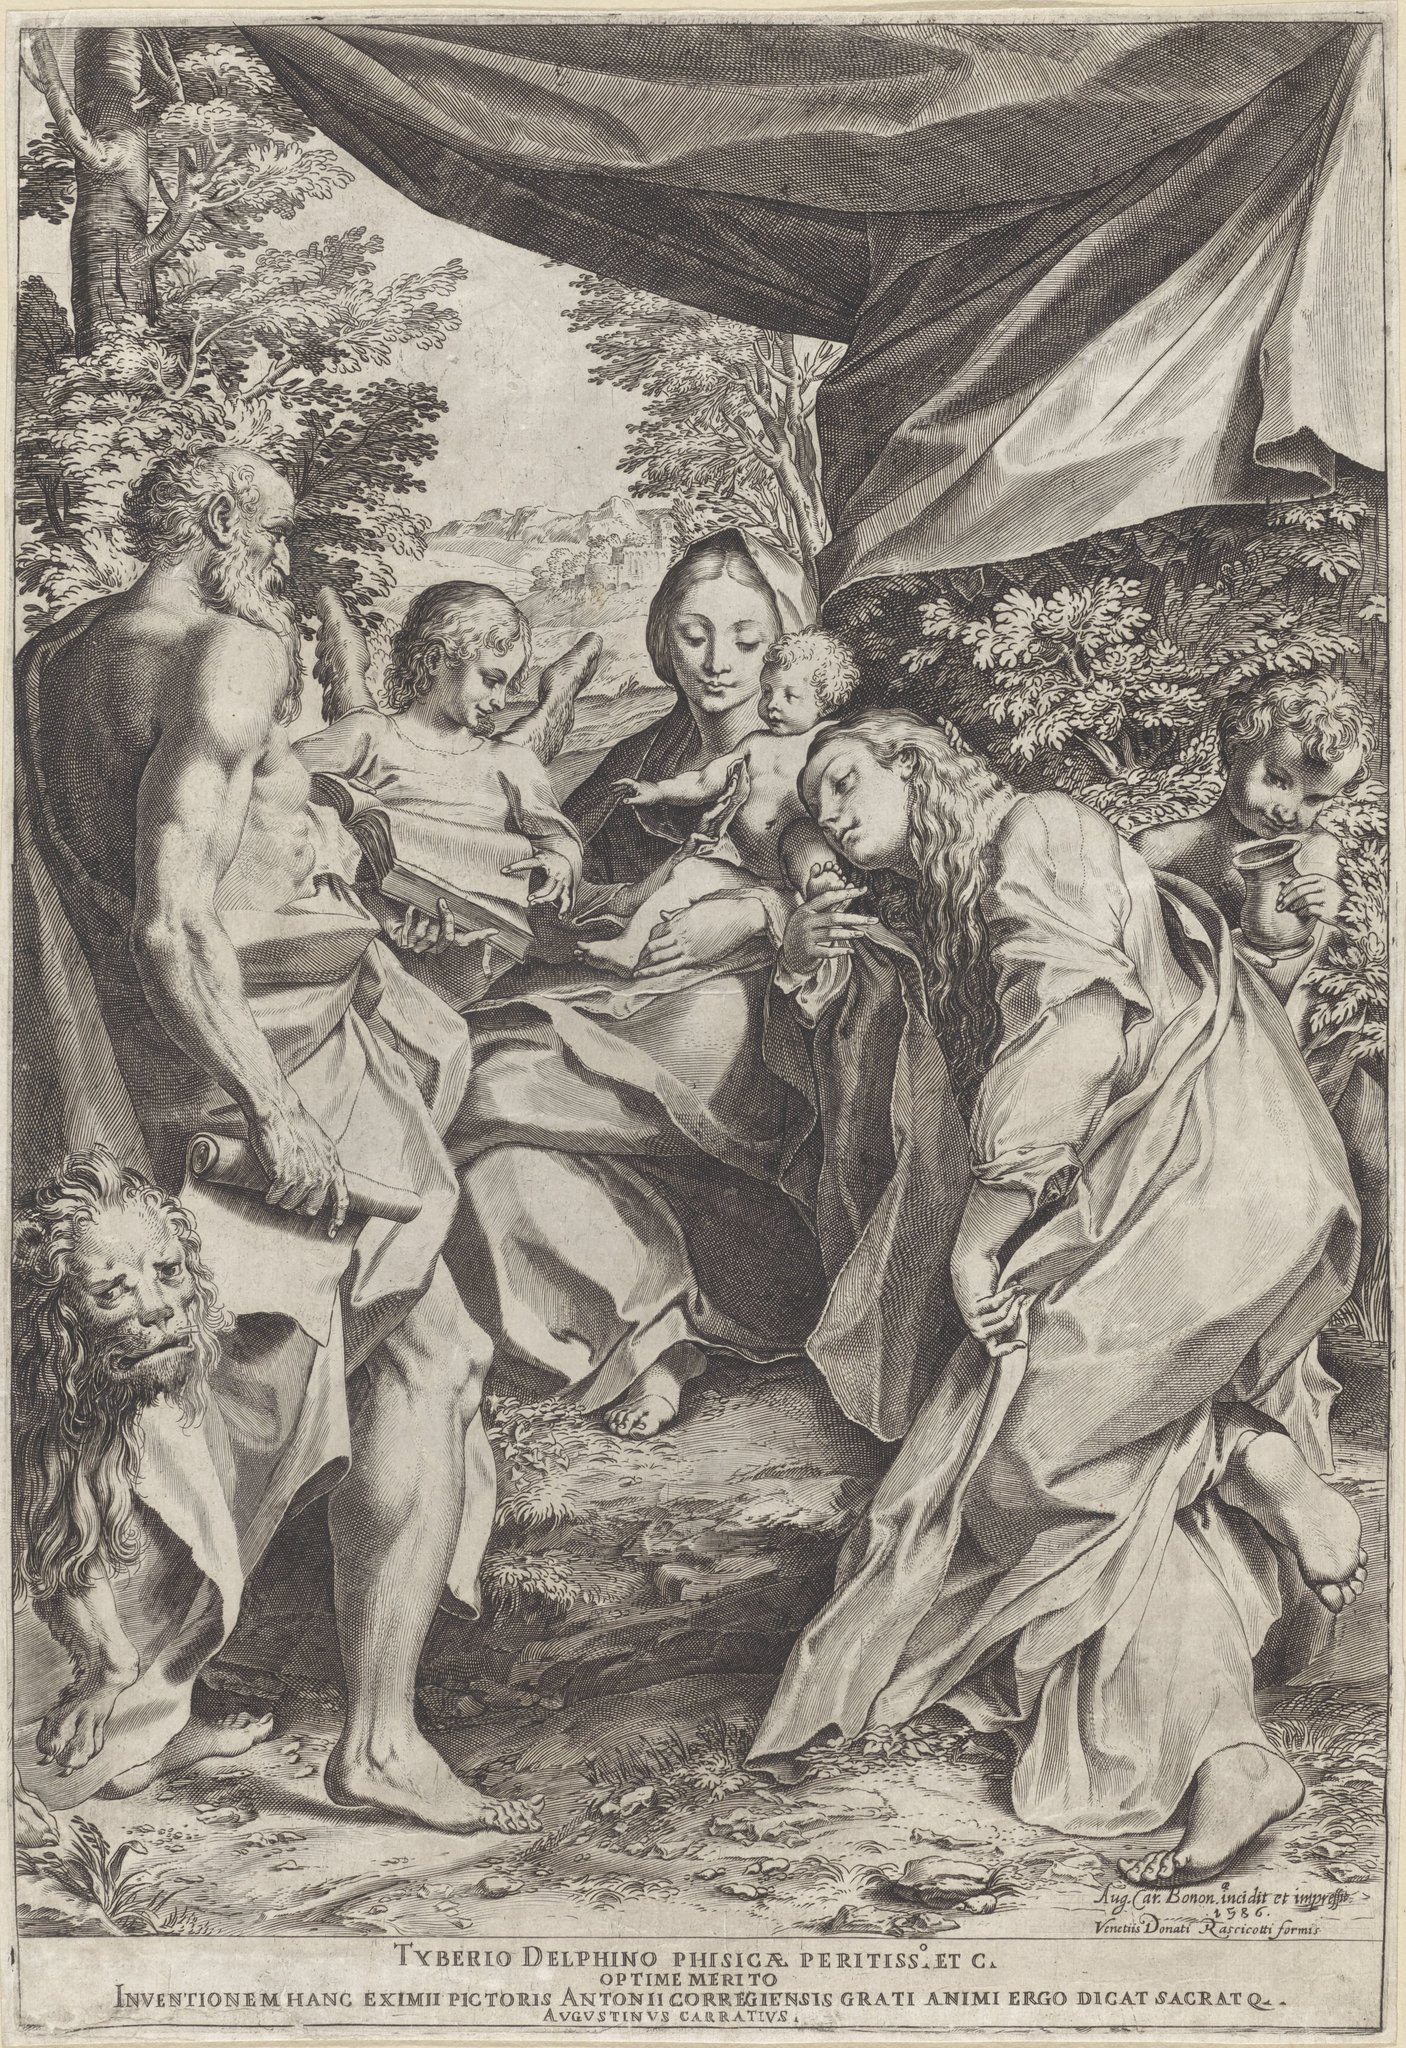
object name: print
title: Maria met Kind en de heilige Hieronymus en Maria Magdalena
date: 1586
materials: paper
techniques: engraving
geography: italy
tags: madonna accompanied by saint(s), the monk and hermit jerome (hieronymus); possible attributes: book, cardinal's hat, crucifix, hour-glass, lion, skull, stone, the penitent harlot mary magdalene; possible attributes: book (or scroll), crown, crown of thorns, crucifix, jar of ointment, mirror, musical instrument, palm-branch, rosary, scourge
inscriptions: collector's mark: Lugt 240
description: Het Christuskind zit bij Maria op schoot. Een engel toont hem een boek. Op de voorgrond links staat de heilige Hieronymus met een leeuw. Rechts knielt de heilige Maria Magdalena en streelt met haar wang langs het been van Christus. Rechts een kleine jongen met een zalfpot.